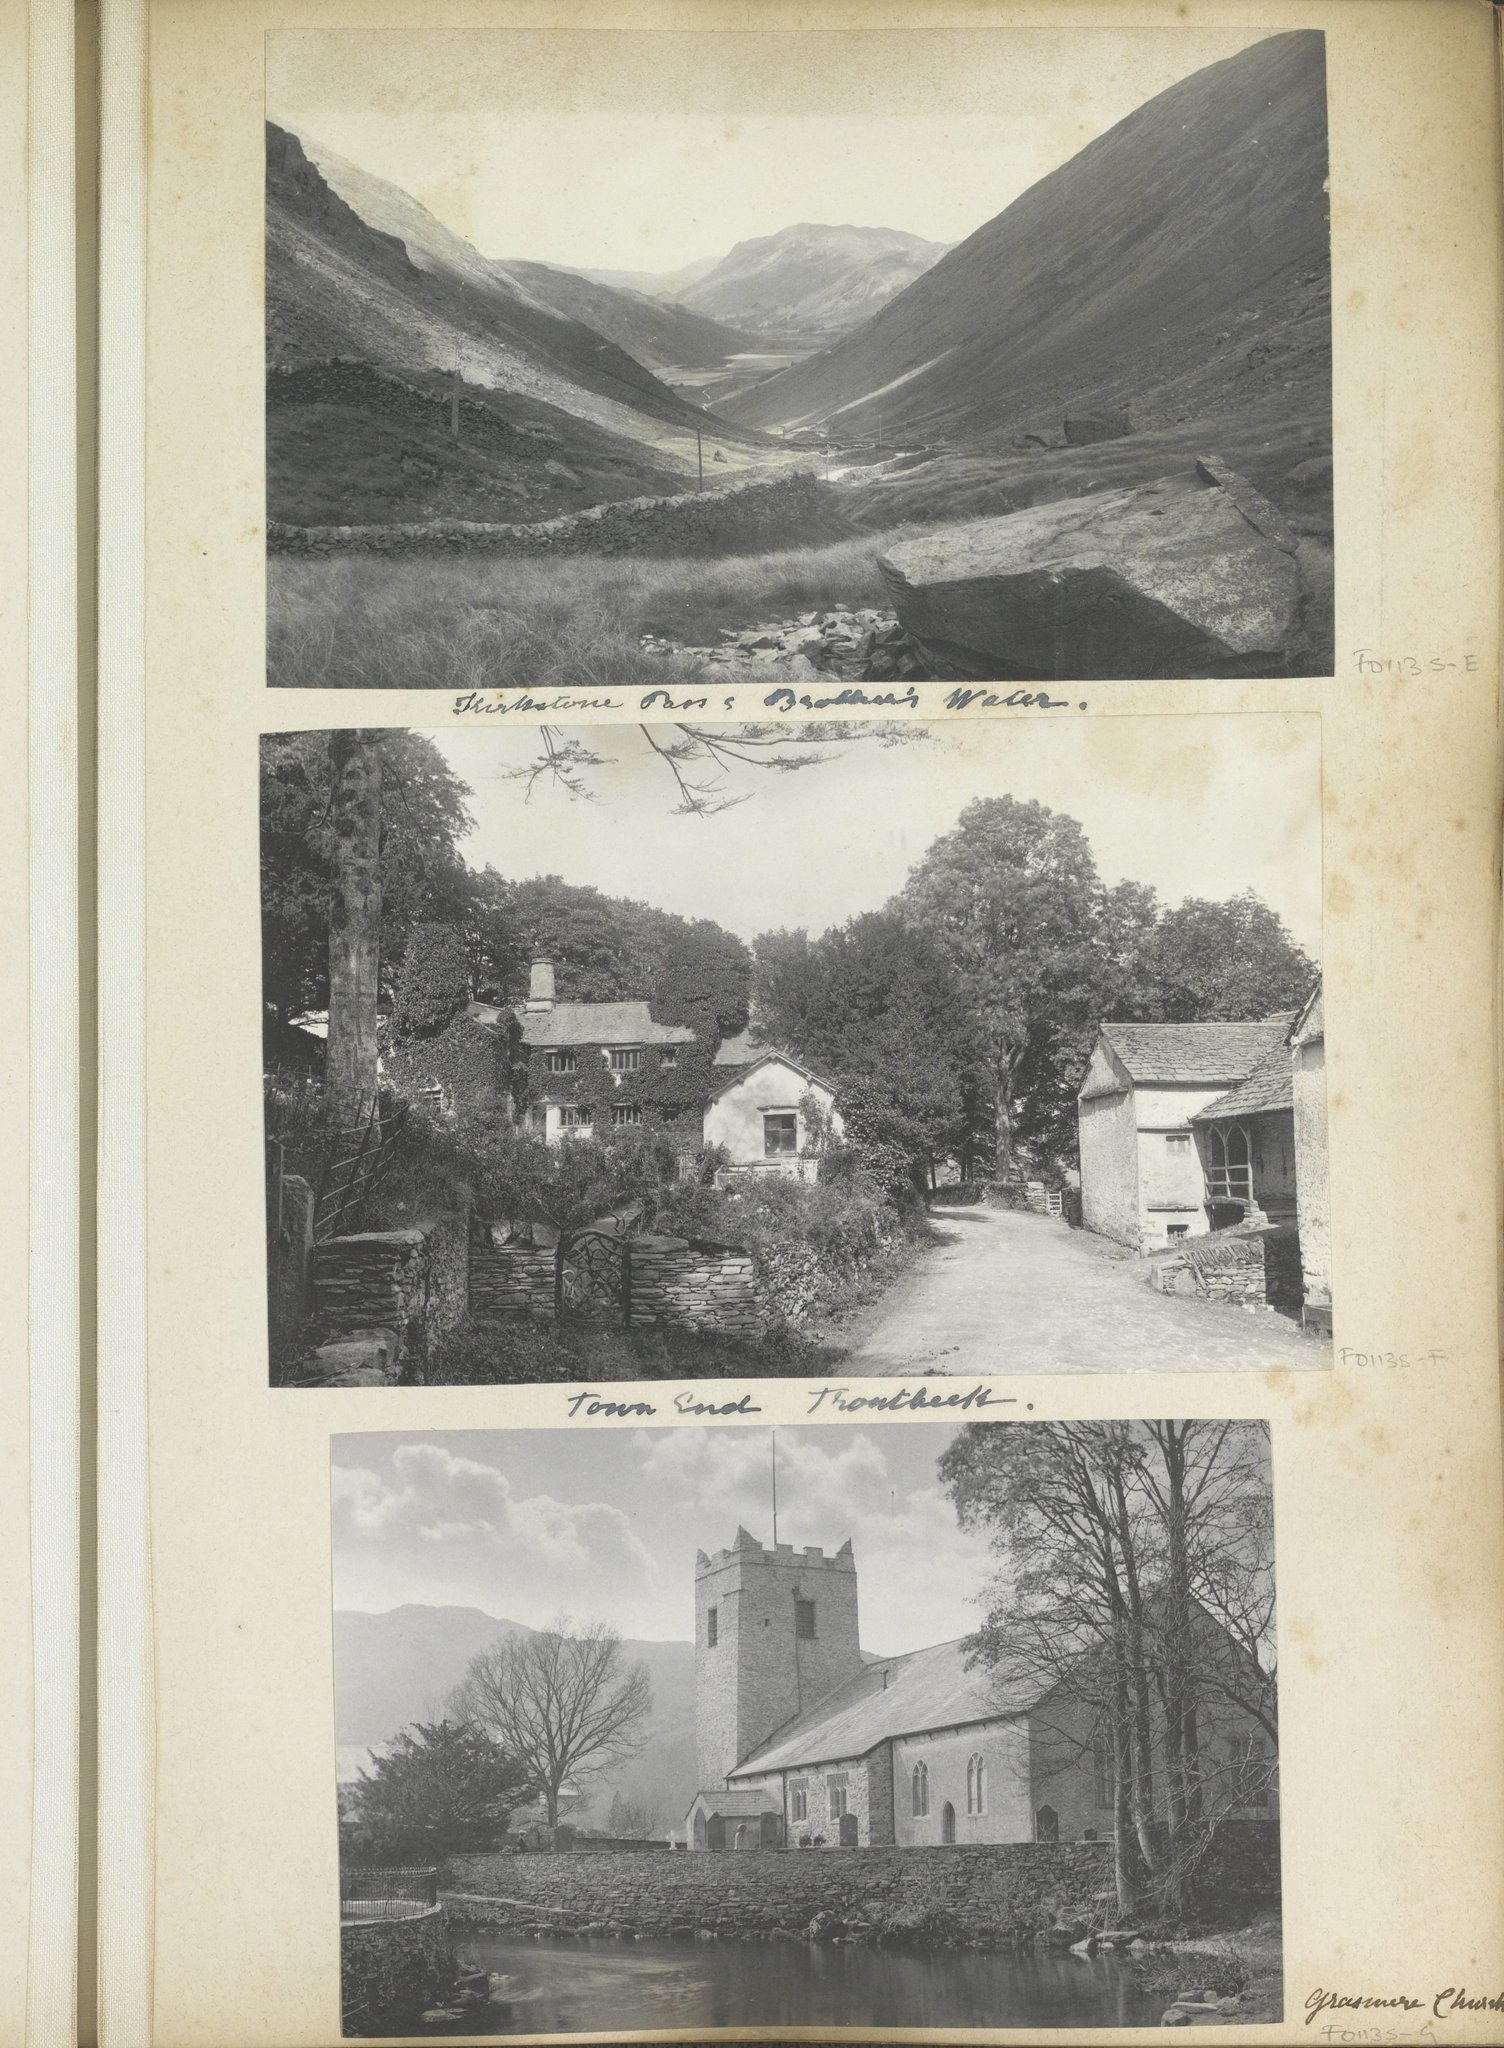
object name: photograph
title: Gezicht op een bergvallei bij Brothers Water in het Lake District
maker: Anonymous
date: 1898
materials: paper, photographic support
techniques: platinum process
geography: lake district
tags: dale, valley, (high) hill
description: Onderdeel van Reisalbum met foto's van bezienswaardigheden in Engeland en Frankrijk.